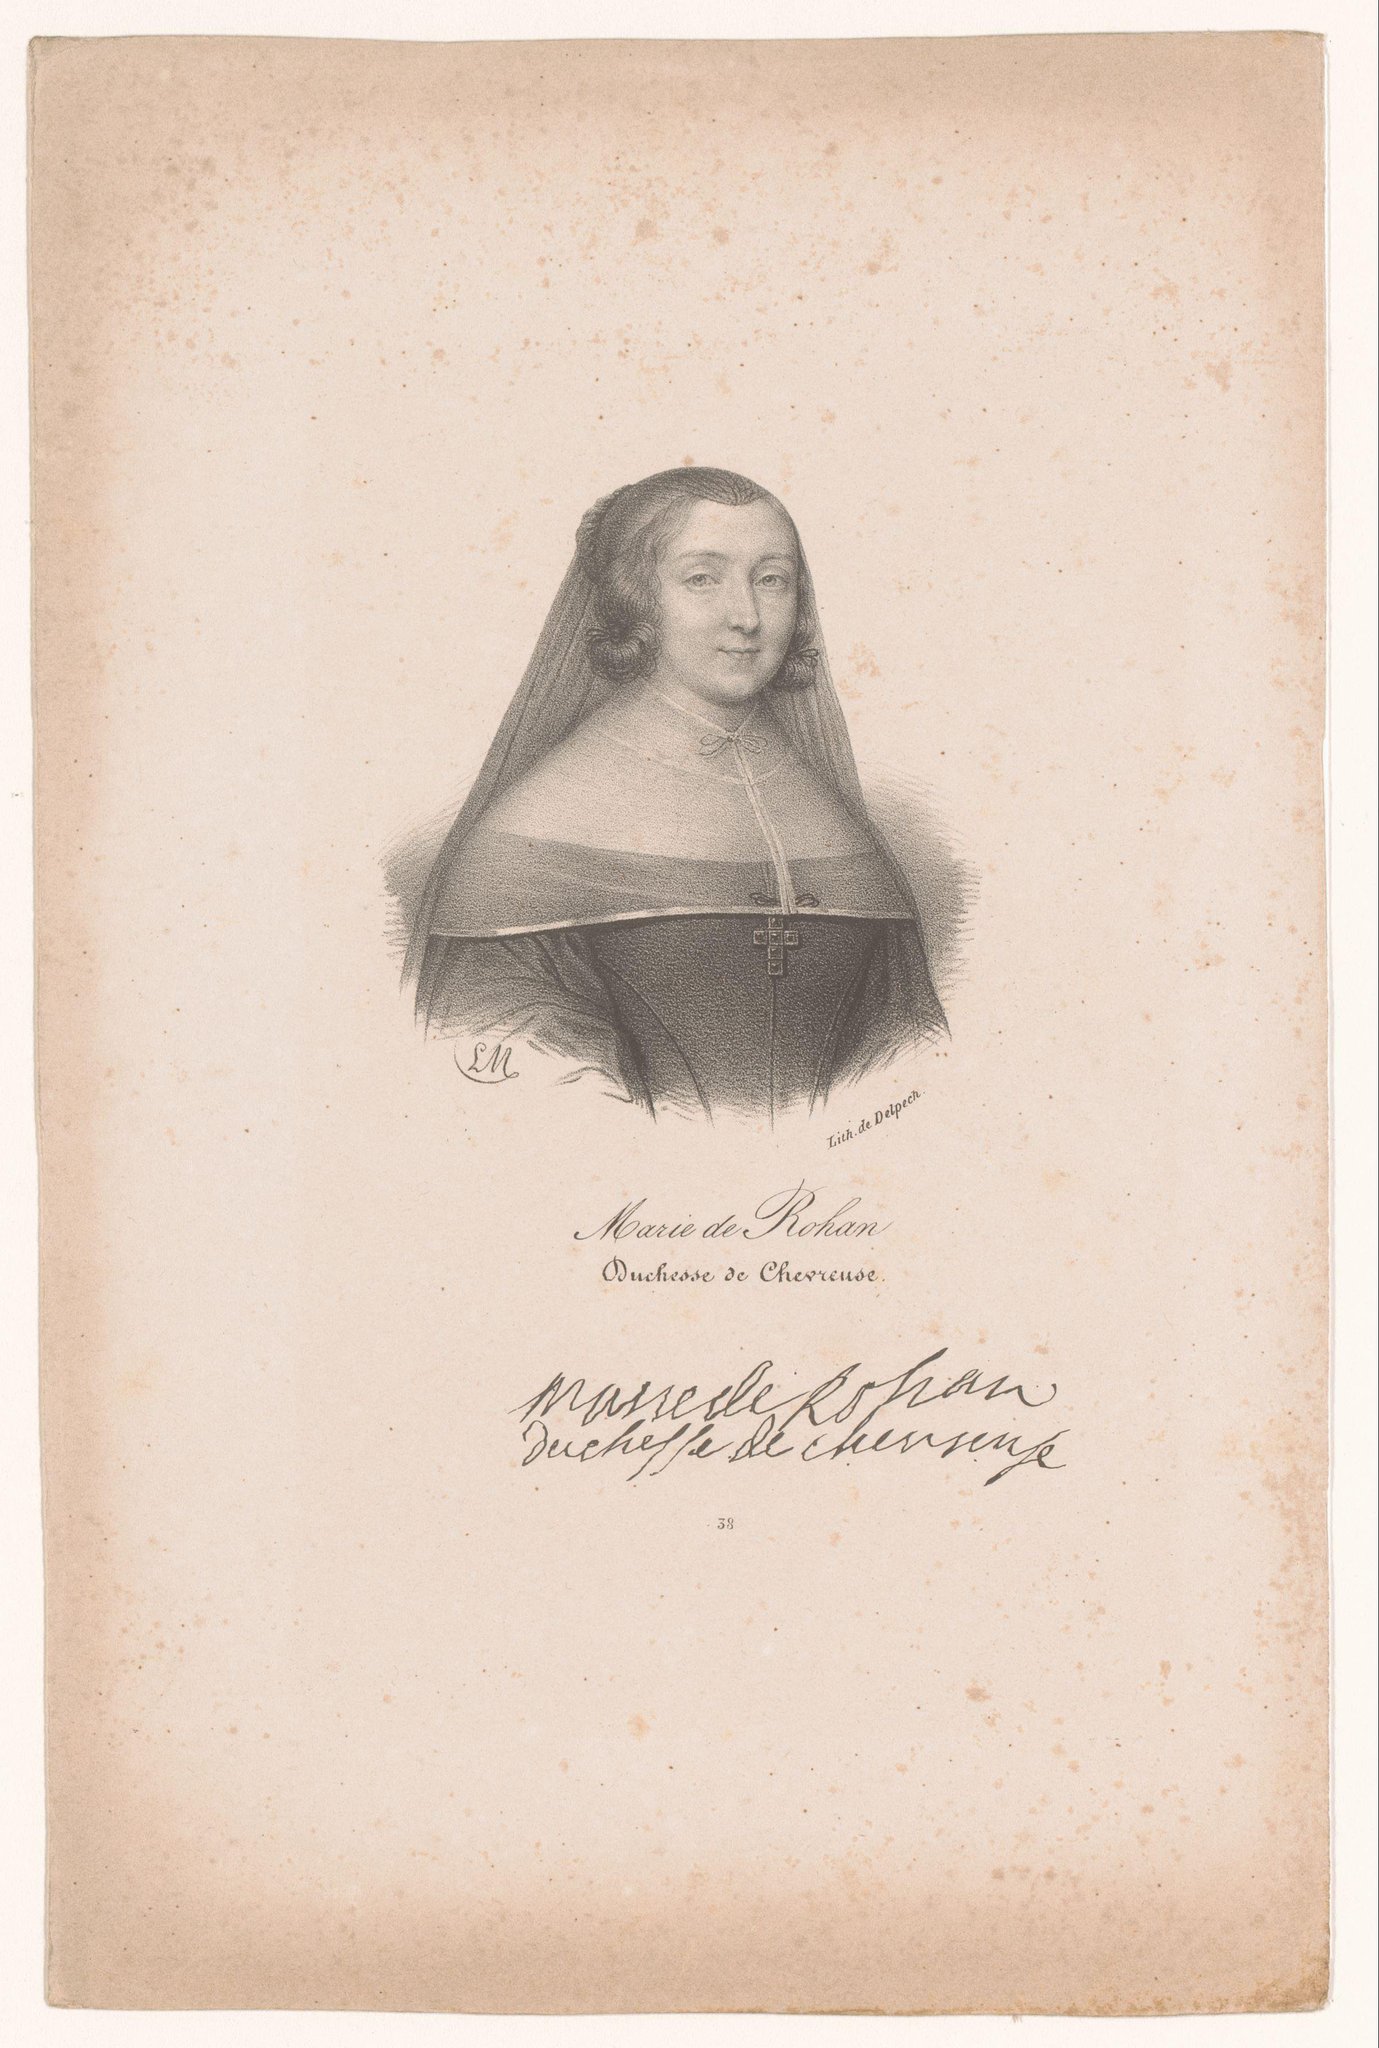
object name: print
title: Portret van Marie de Rohan, hertogin van Chevreuse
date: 1825-1842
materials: paper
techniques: lithograph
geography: paris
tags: historical persons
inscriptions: collector's mark: Lugt 2228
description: Prent waarschijnlijk gebruikt voor: Iconographie française ou recueil des portraits des personnages les plus illustres qui ont paru en France depuis François premier jusqu'à la fin du règne de Louis XVI (…). Parijs: veuve Delpech, 1828. En/of voor: Iconographie française ou choix de deux cents portraits d'hommes et de femmes qui se sont acquis en France, depuis le règne de Charles VII jusqu'à la fin de celui de Louis XVI (…). Parijs: veuve Delpech, 1840. Mogelijk komt de prent ook voor in eerdere en/of latere publicaties uitgegeven door veuve Delpech of haar opvolger Rosselin.